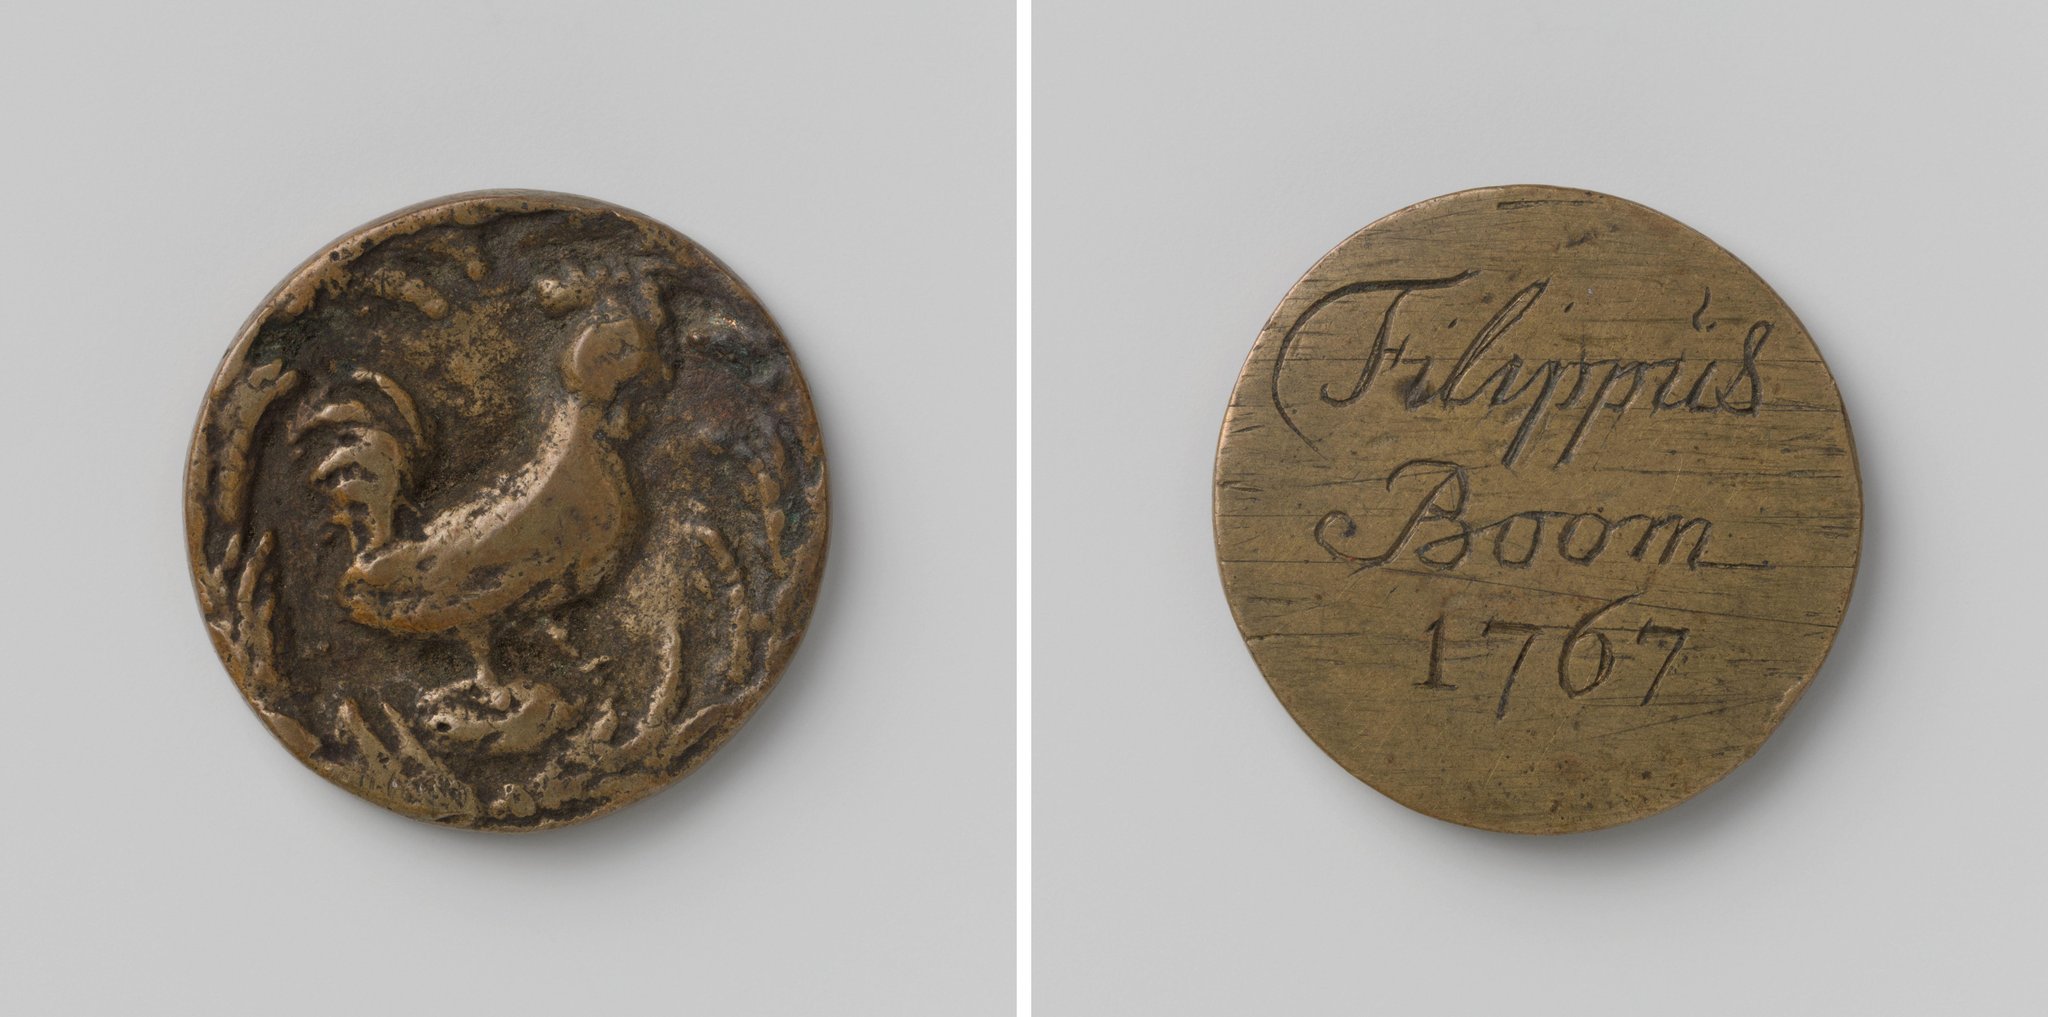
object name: medal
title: Hoender-, konijn- en vogelverkopersgilde van Amsterdam, gildepenning van Filippus Boom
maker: Anonymous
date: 1767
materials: brass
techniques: casting, engraving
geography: amsterdam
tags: amsterdam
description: Messing penning. Voorzijde: naar rechts gewende haan binnen bladerkrans. Keerzijde: opschrift